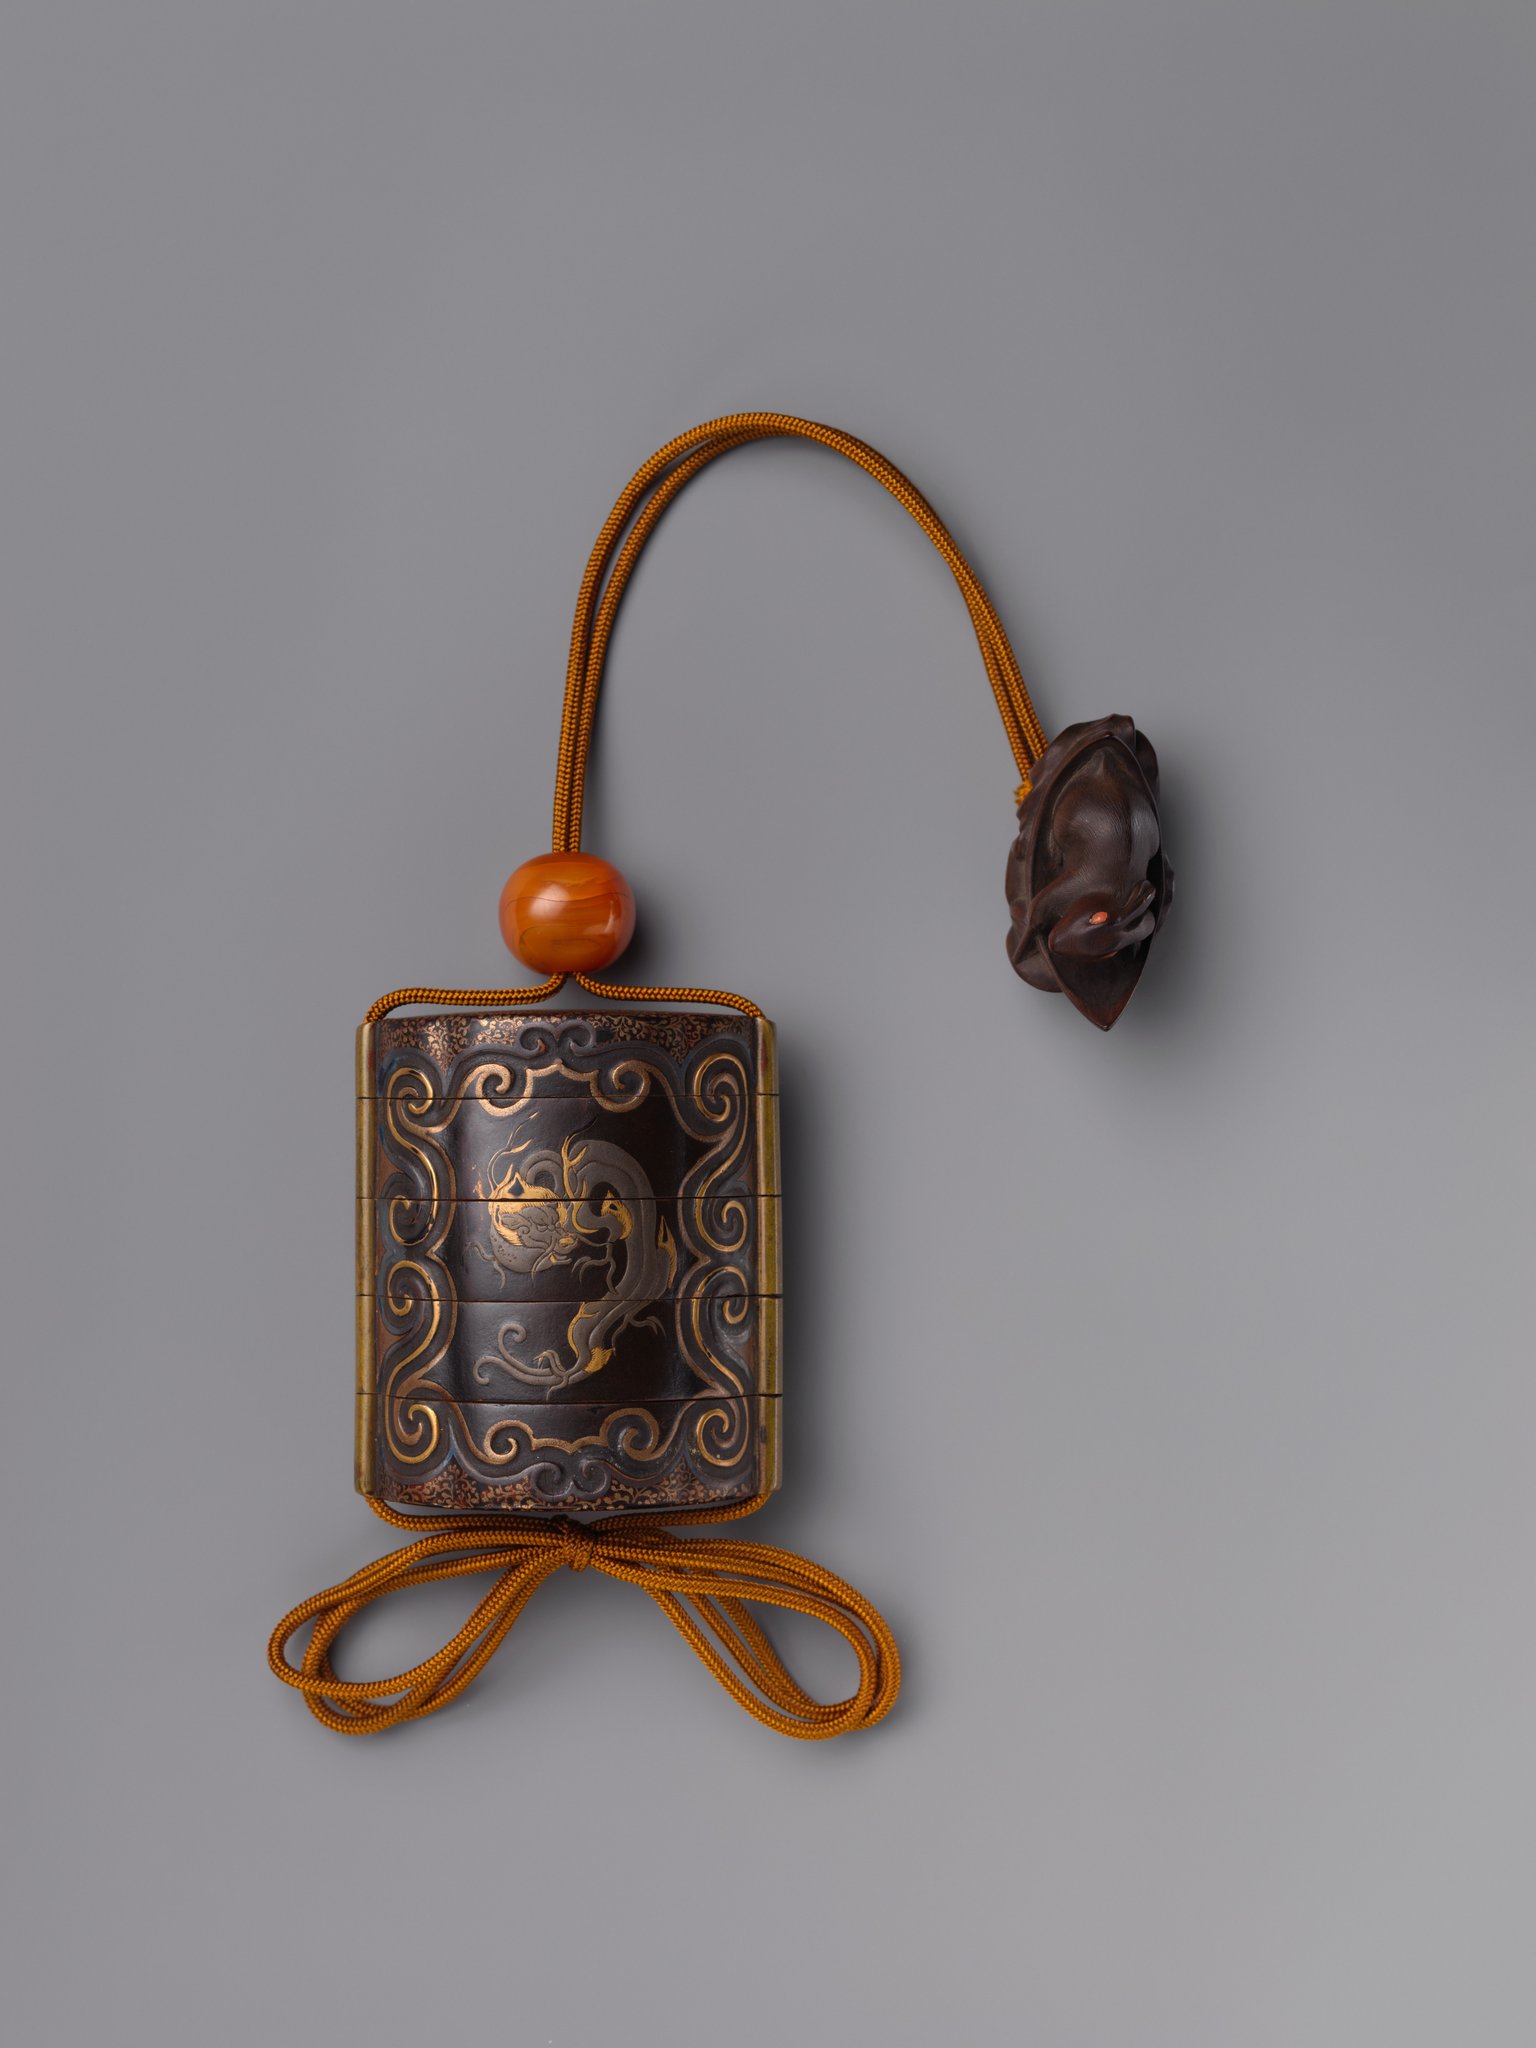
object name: inrō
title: Inrō with Dragon in Cartouche on Arabesque Foliage (Karakusa) Background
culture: japanese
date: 1701-1800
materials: stone, cord, gold, lacquer, metal, silver, wood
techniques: carving, hiramakie, lacquer, maki-e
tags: dragons